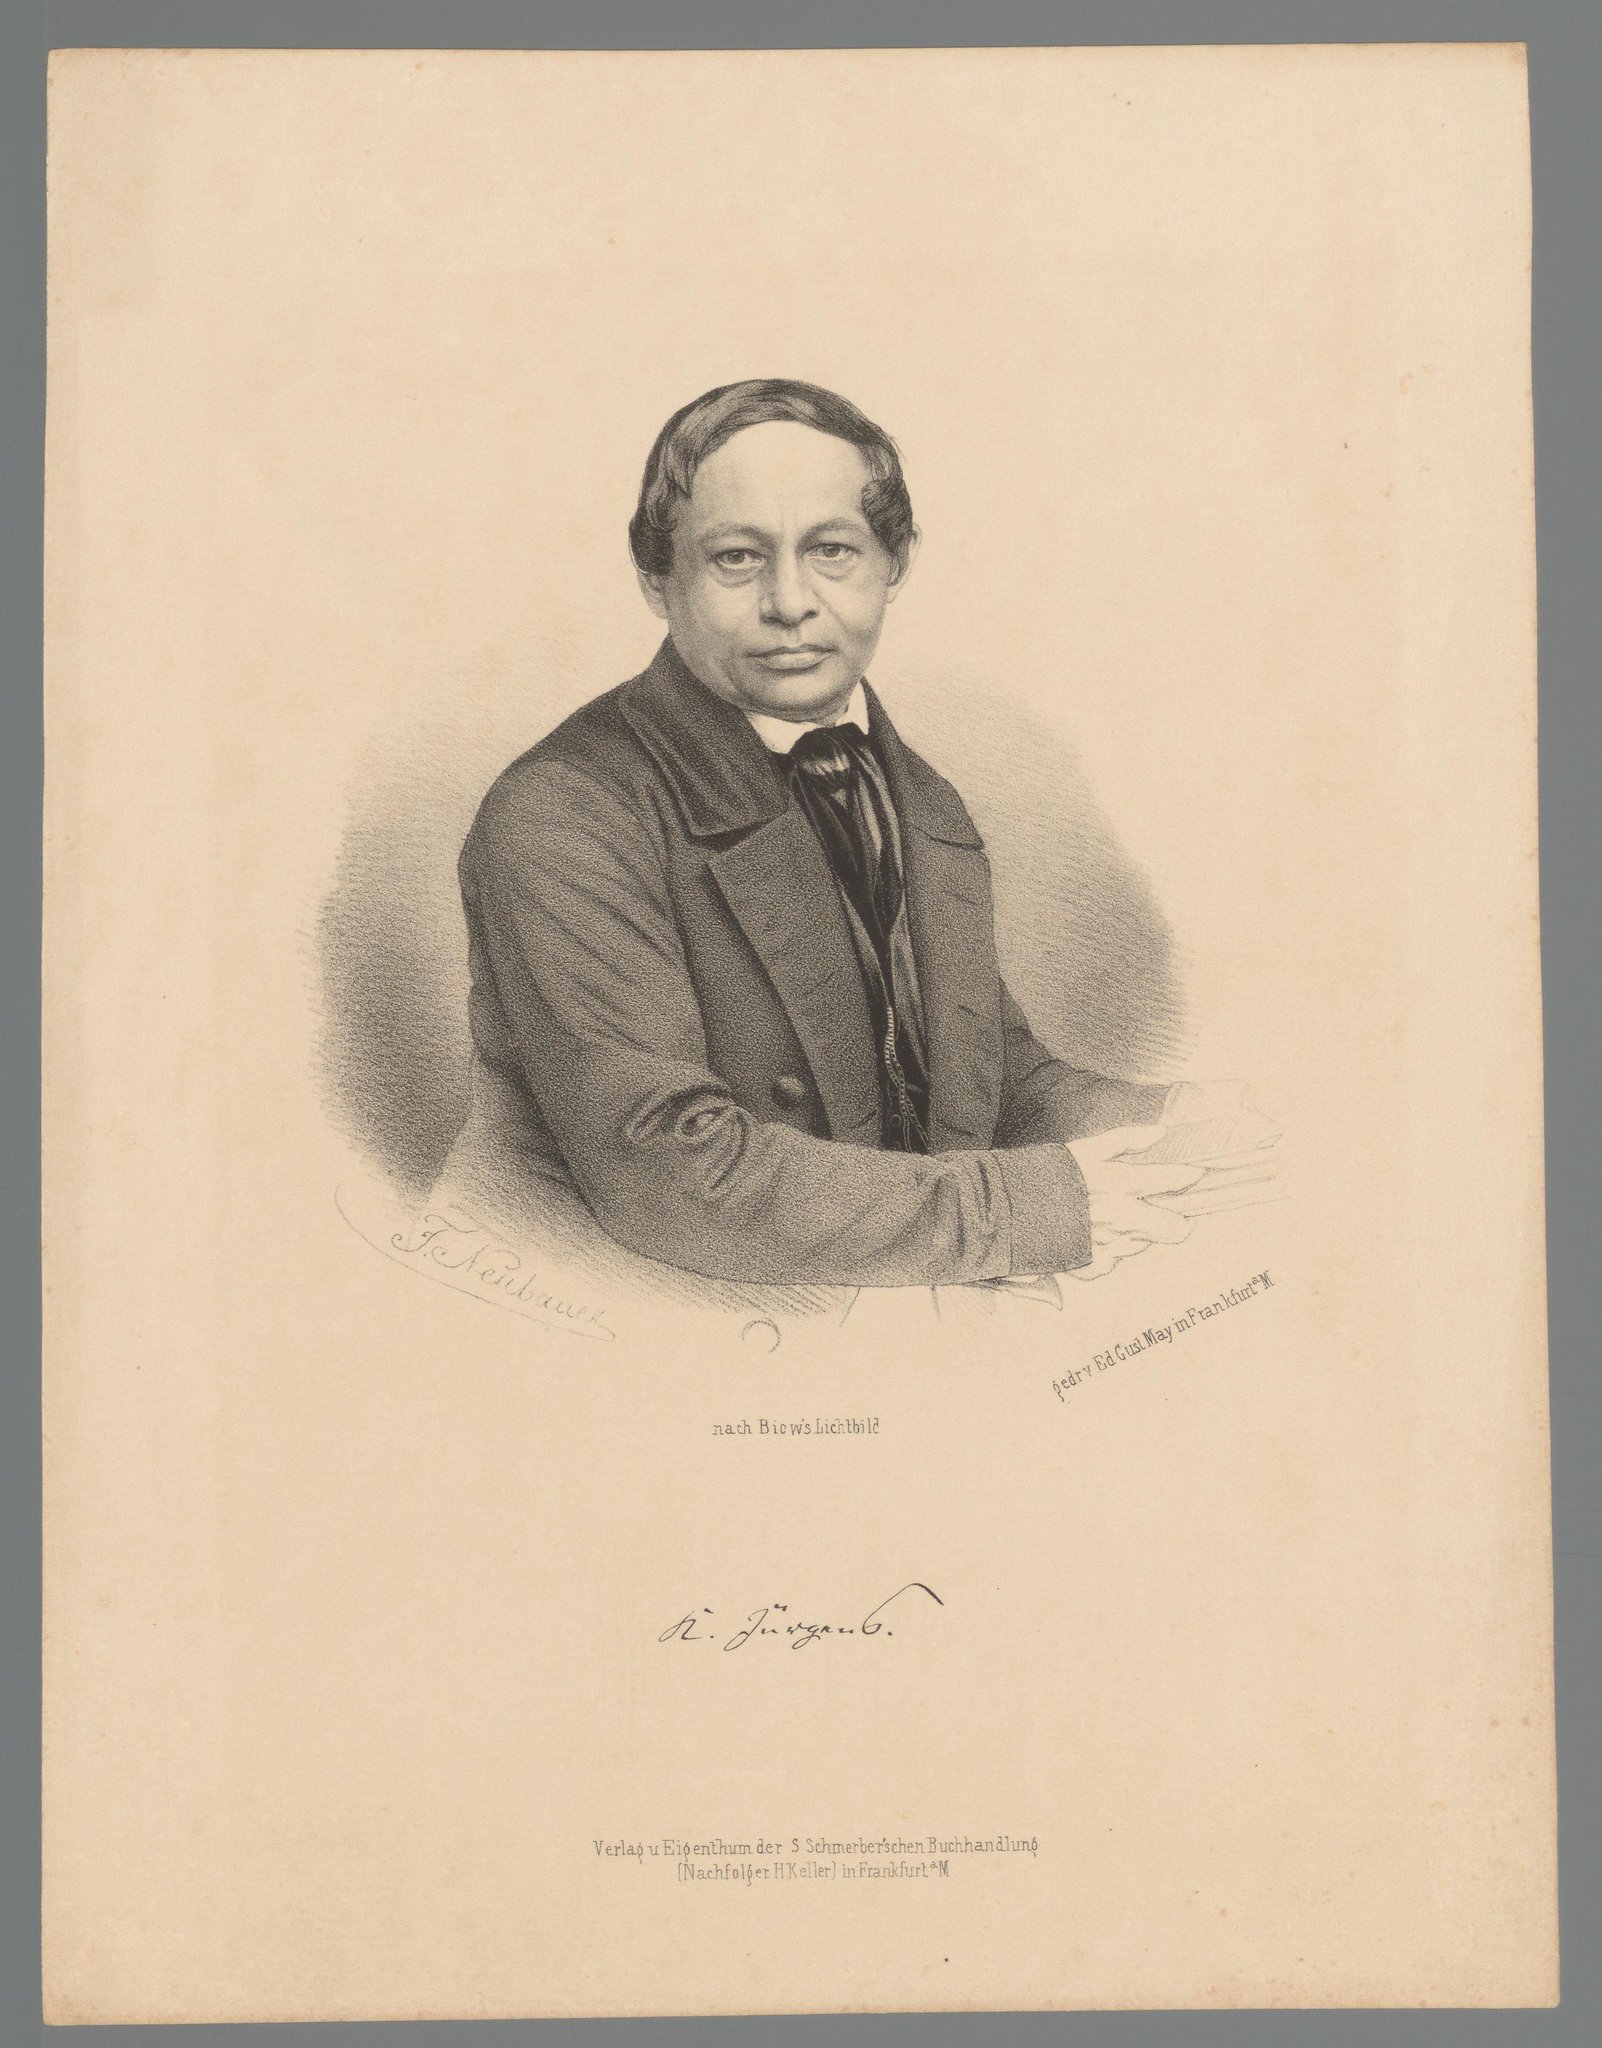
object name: print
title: Portret van een onbekende man, mogelijk Jürgens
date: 1835-1875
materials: paper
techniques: lithograph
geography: frankfurt am main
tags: adult man, historical persons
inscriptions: collector's mark: Lugt 2228